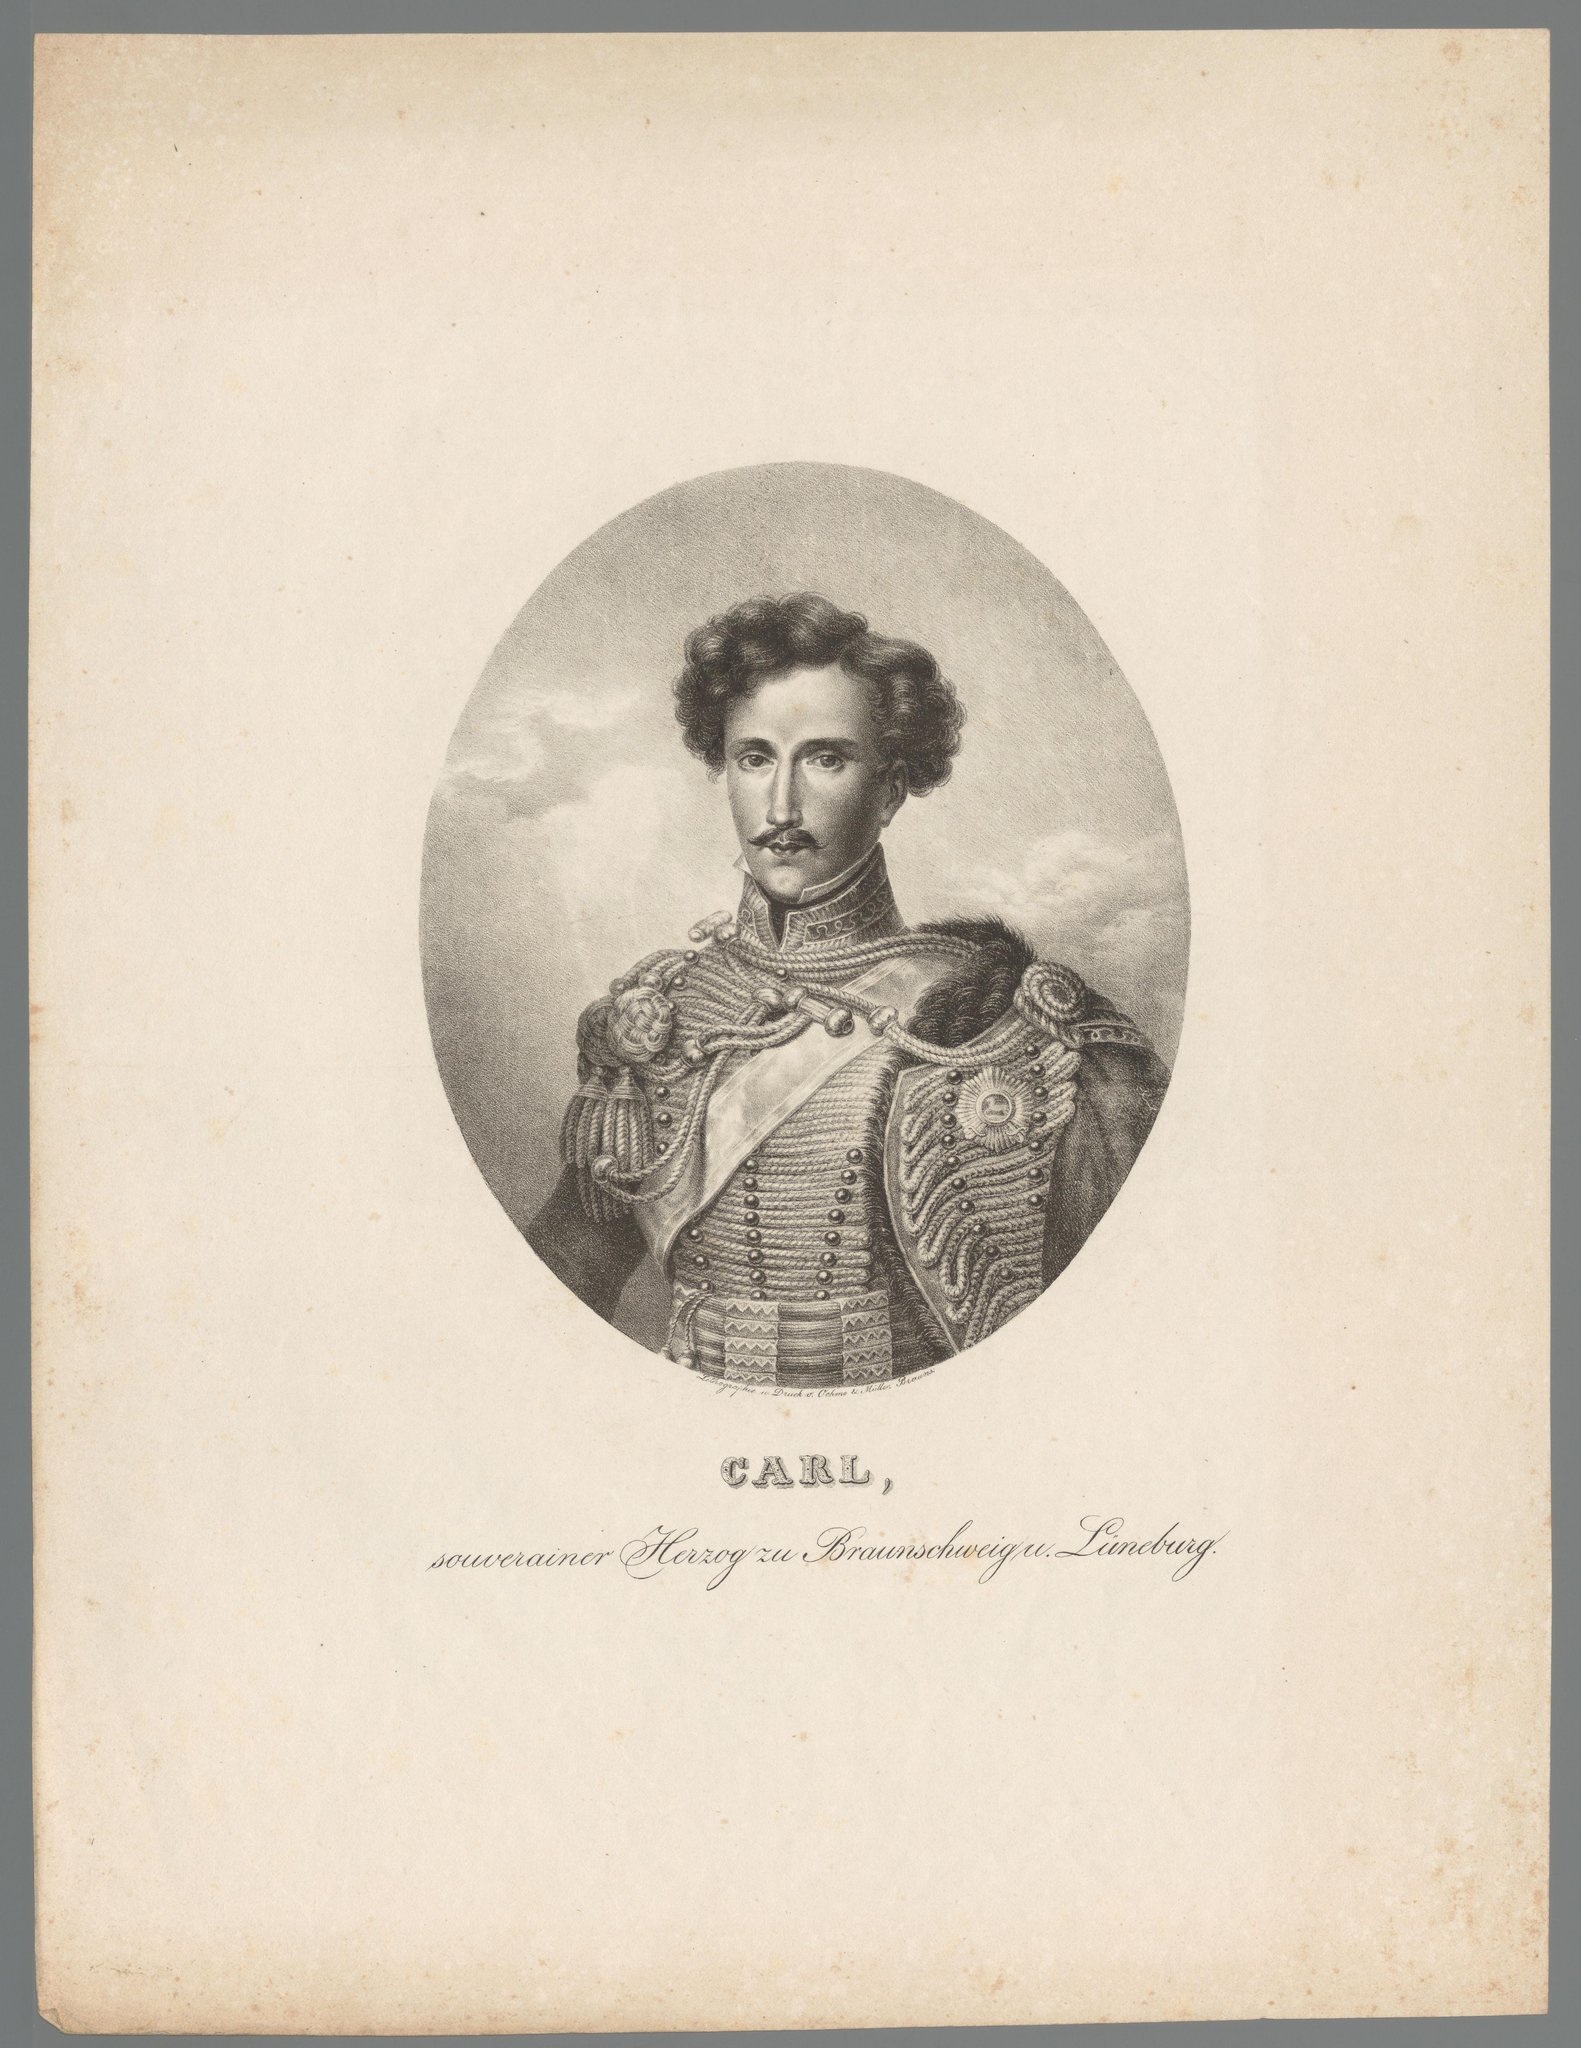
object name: print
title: Carl, souverainer Herzog zu Braunschweig u. Lüneburg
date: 1825-1850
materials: paper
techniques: lithograph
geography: braunschweig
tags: moustache, adult man, historical persons, (military) uniforms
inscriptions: collector's mark: Lugt 2228